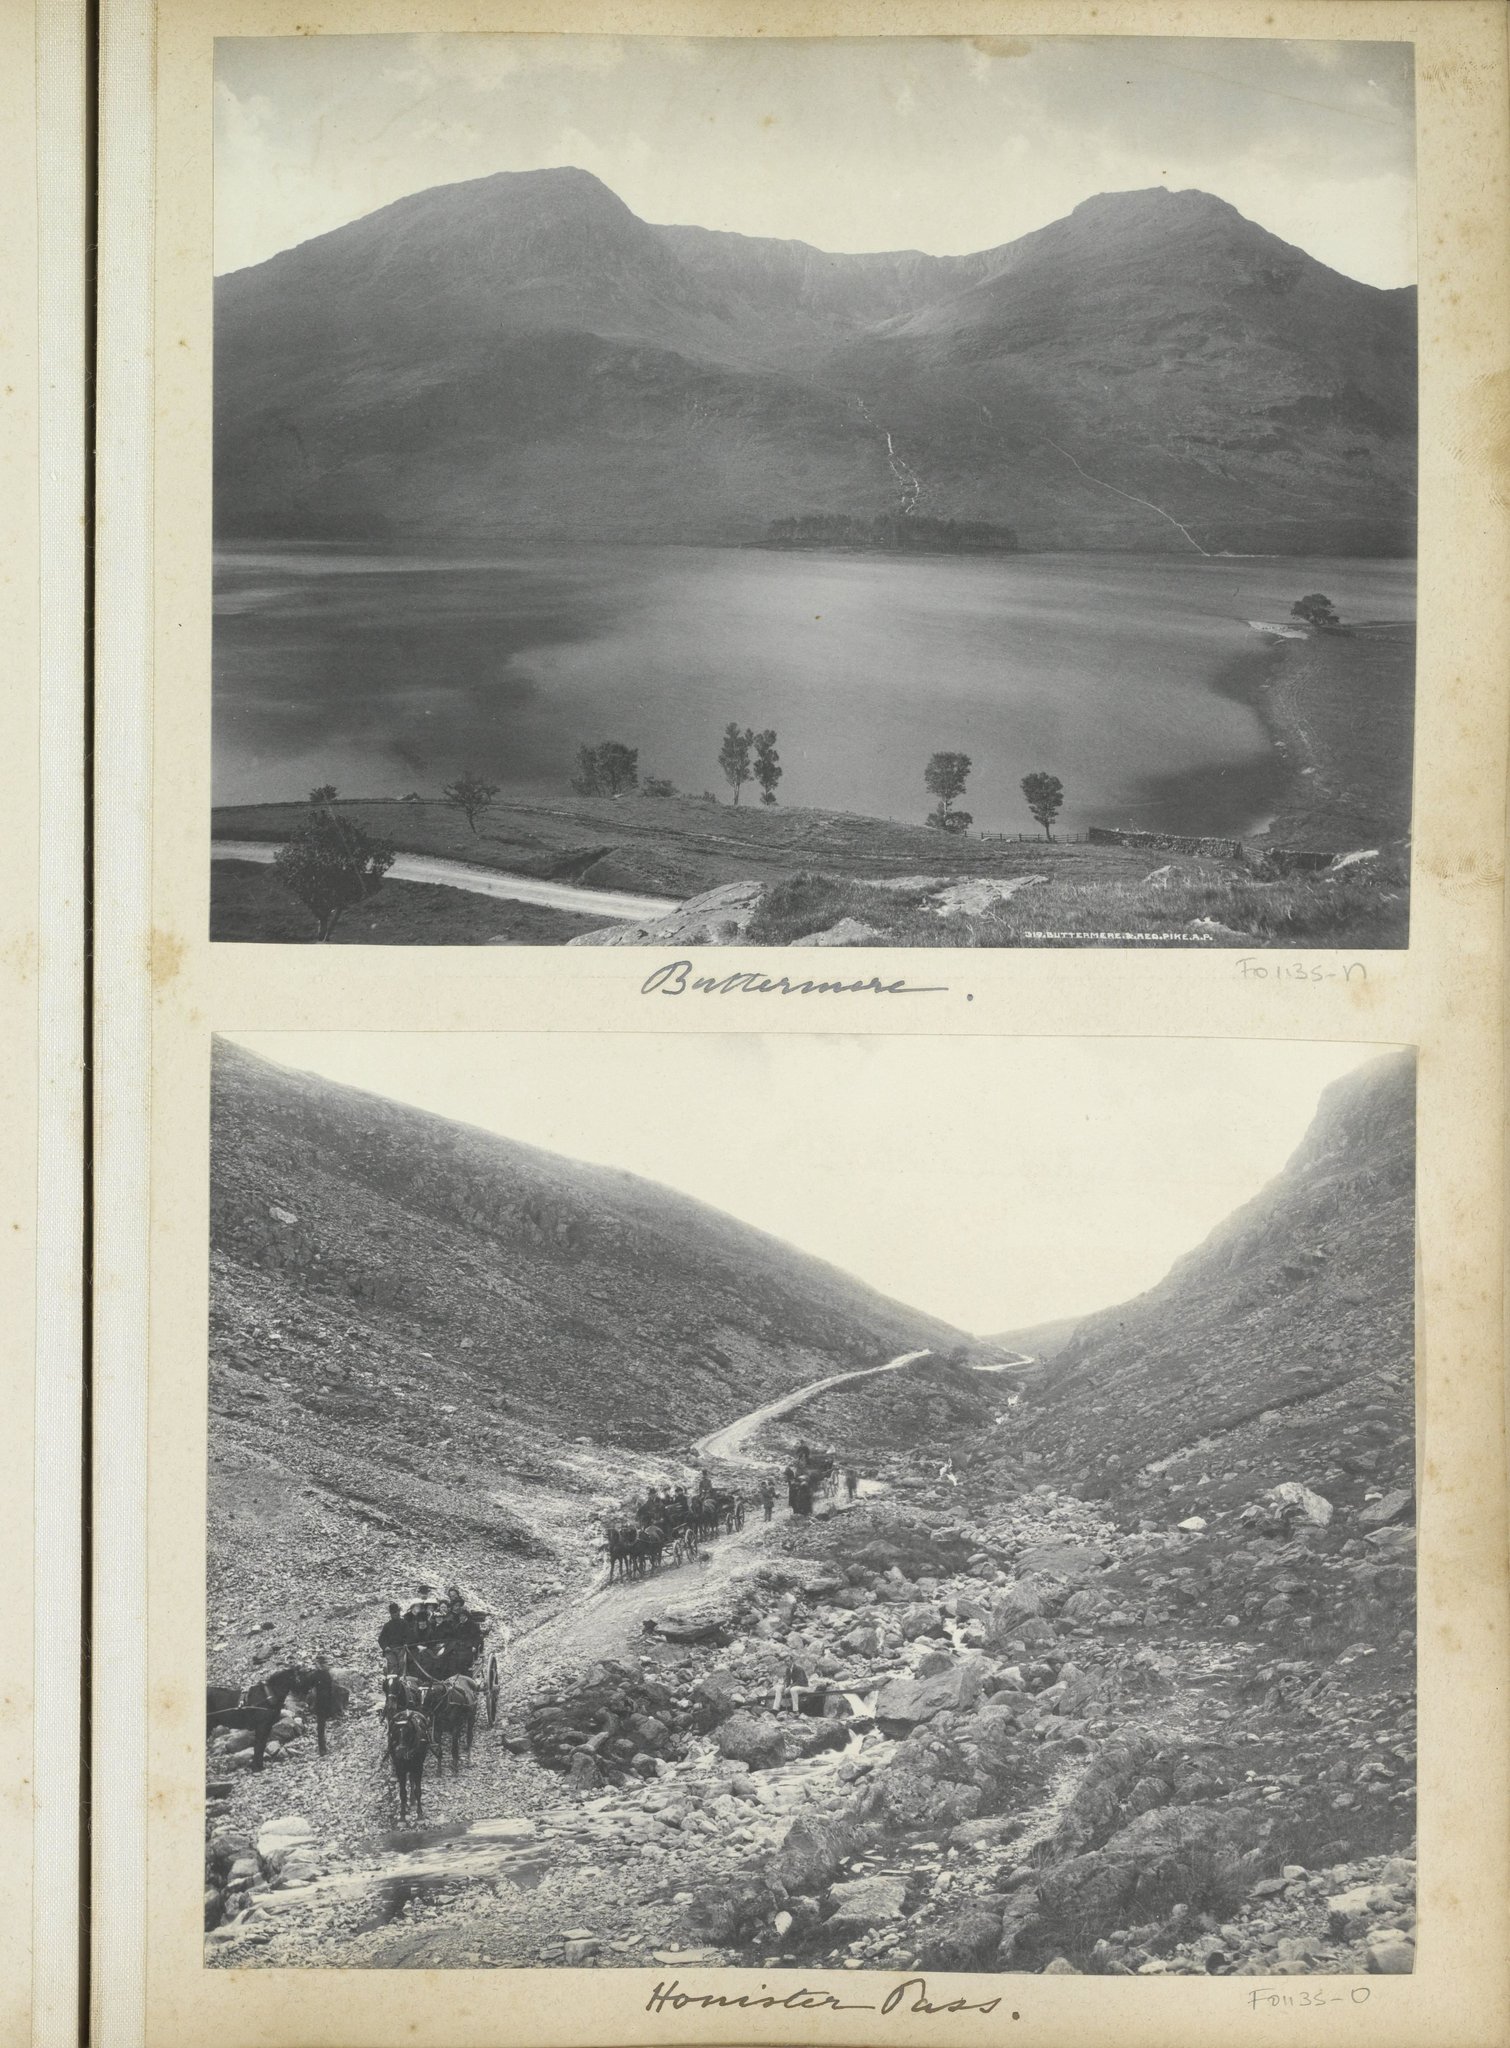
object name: album leaf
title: Gezelschap met paardenkoetsen in de Honister Pass in het Lake District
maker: Anonymous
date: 1898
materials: paper, photographic support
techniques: platinum process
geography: honister pass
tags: diligence, omnibus, horse-tram, road, path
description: Onderdeel van Reisalbum met foto's van bezienswaardigheden in Engeland en Frankrijk.